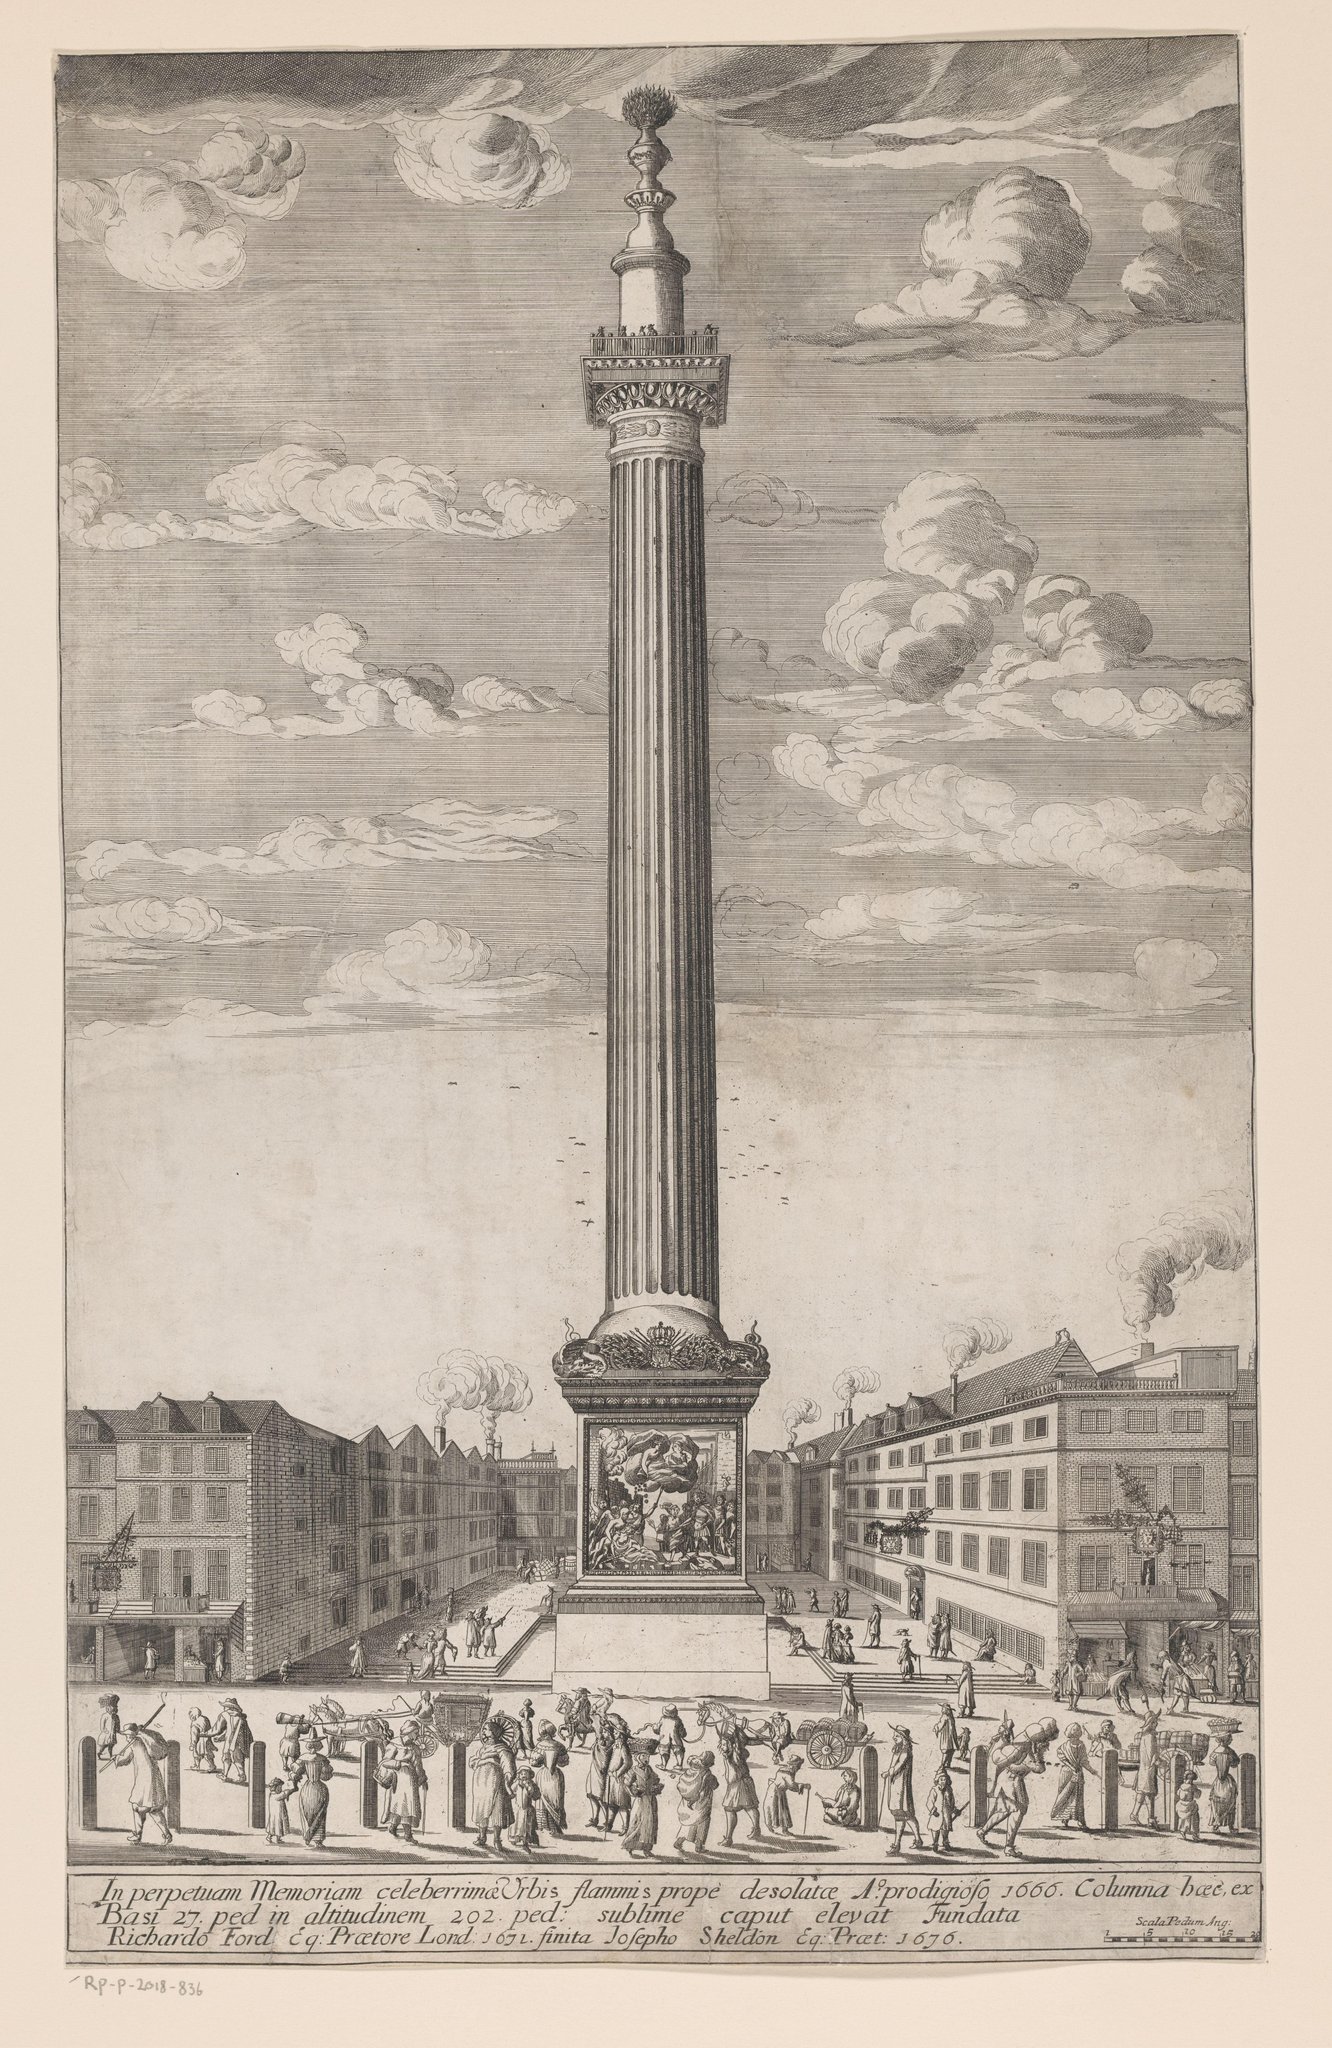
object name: print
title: Gezicht op het 'Monument to the Great Fire of London'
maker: Anonymous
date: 1676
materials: paper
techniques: engraving, etching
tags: monument, statue